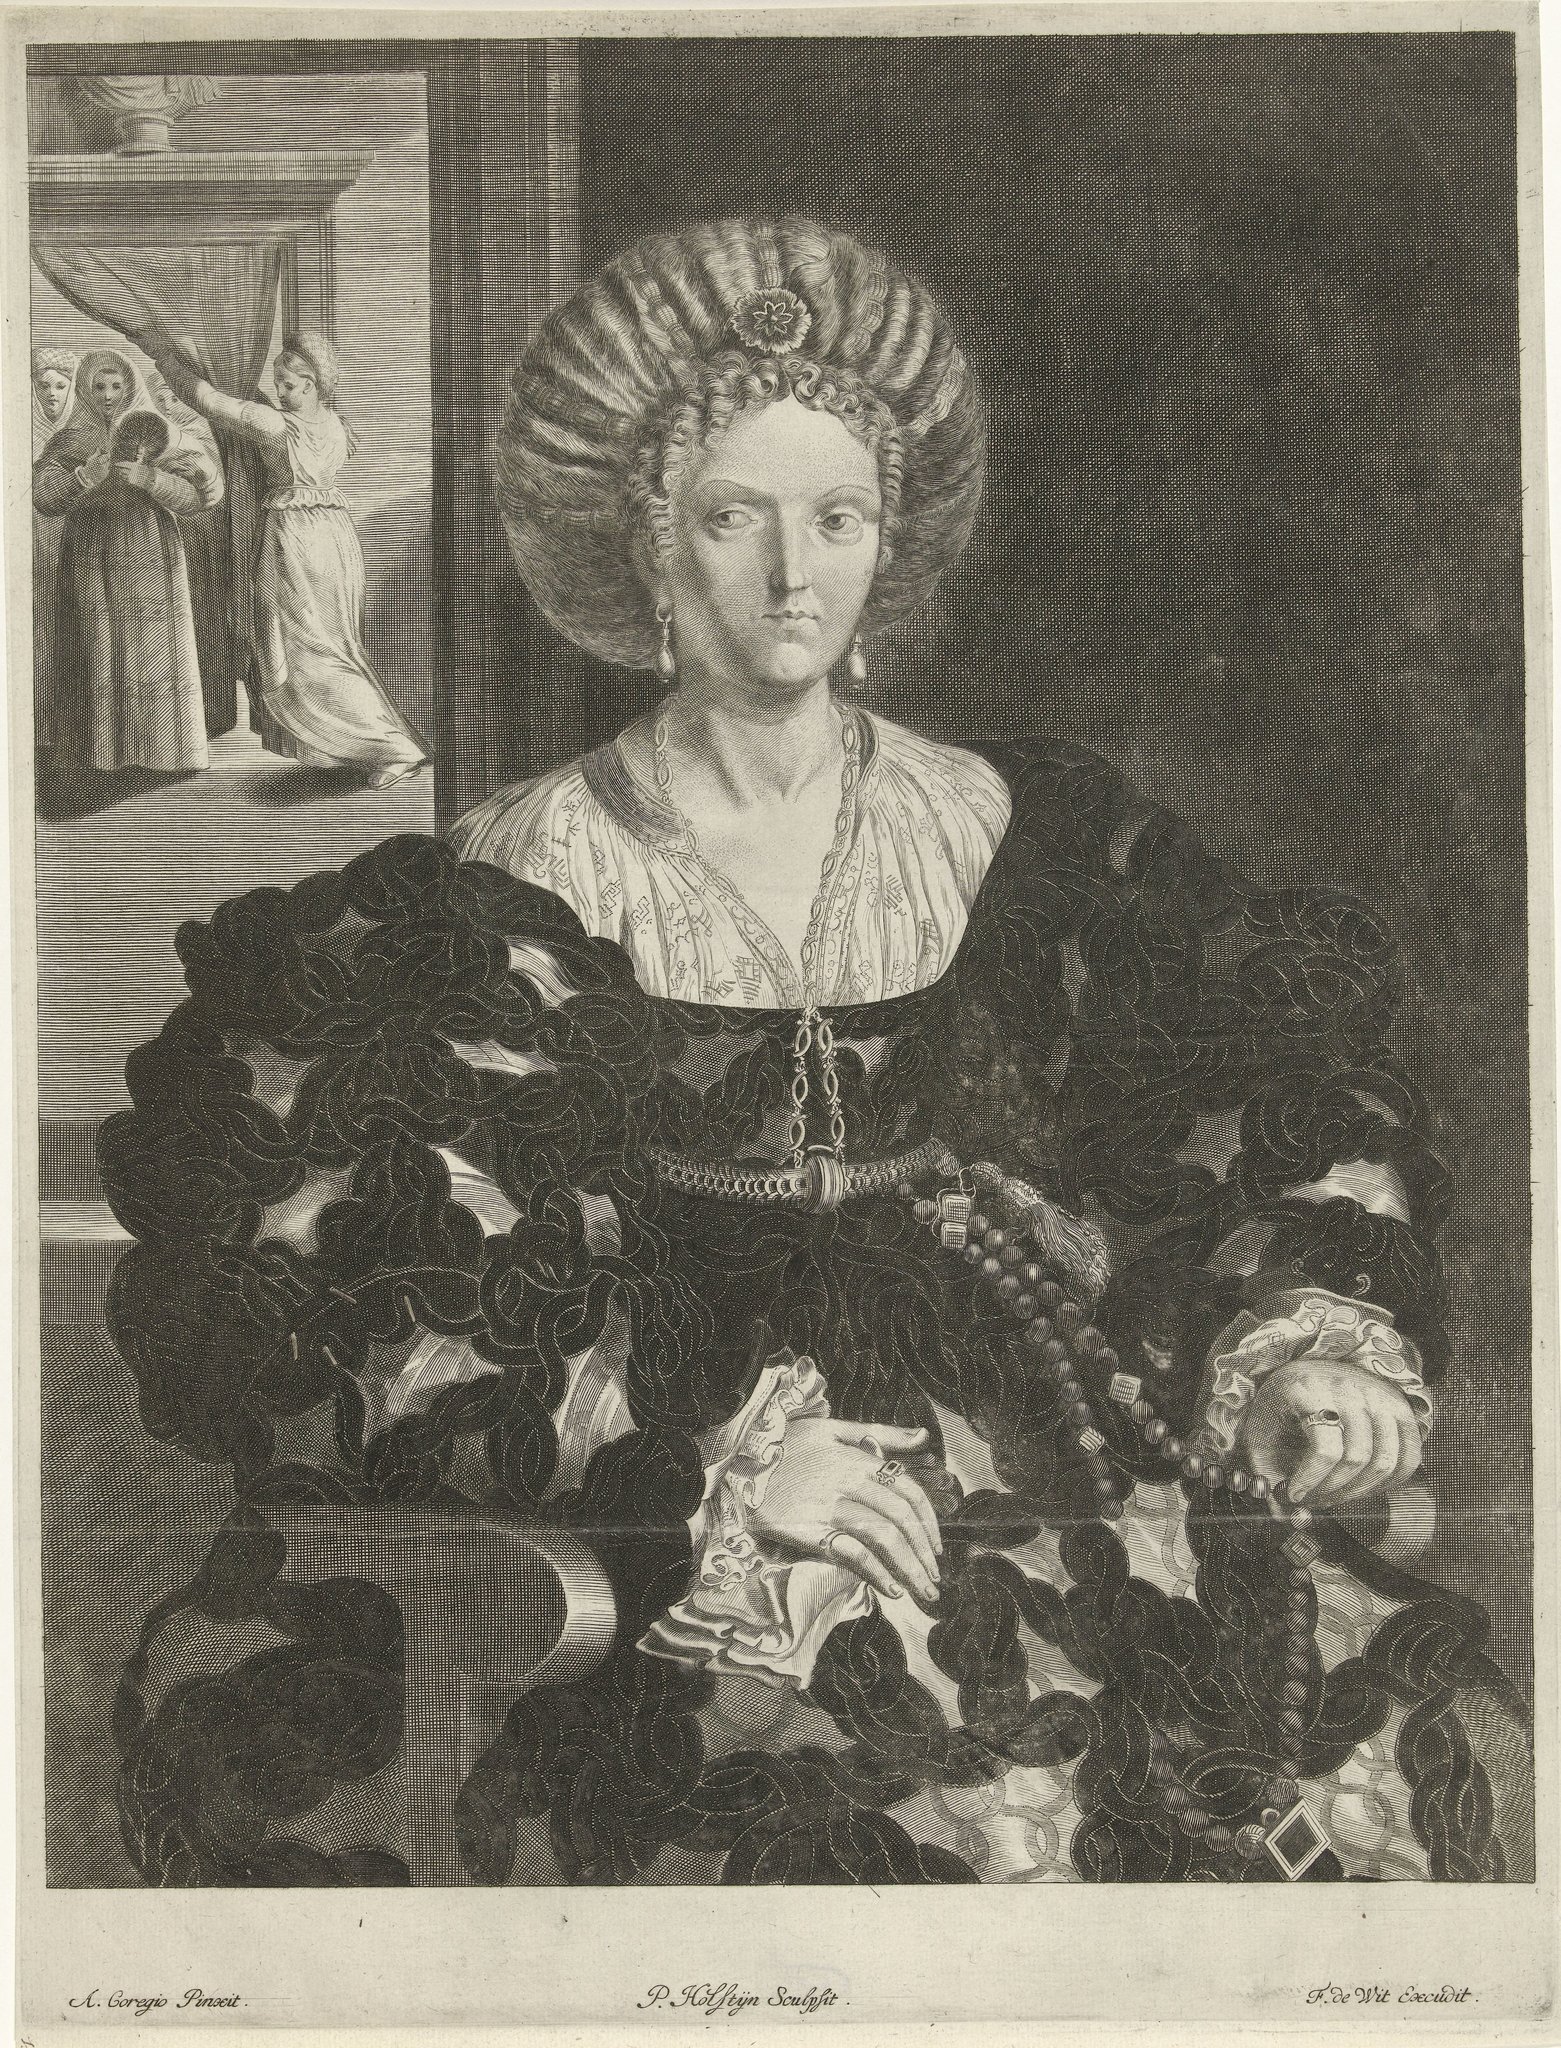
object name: print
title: Portret van Margaret Paleologa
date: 1660-1706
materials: paper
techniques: engraving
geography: northern netherlands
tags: historical persons - bb - woman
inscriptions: collector's mark: Lugt 2228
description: Deze prent maakt mogelijk deel uit van de serie 'Variarum imaginum a celeberrimis artificibus pictarum Caelaturae', bestaande uit 34 prenten die gemaakt zijn naar schilderijen uit de collectie van Gerard Reynst. Koopman Gerard Reynst was de opdrachtgever van de prentserie, maar stierf voordat het werk werd uitgegeven. Destijds stond het geschilderde portret bekend als het portret van Isabella d'Este. Meer recent wordt vermoed dat het een portret van Margherita Paleologo betreft. Het schilderij bevindt zich in de Royal Collection Trust.